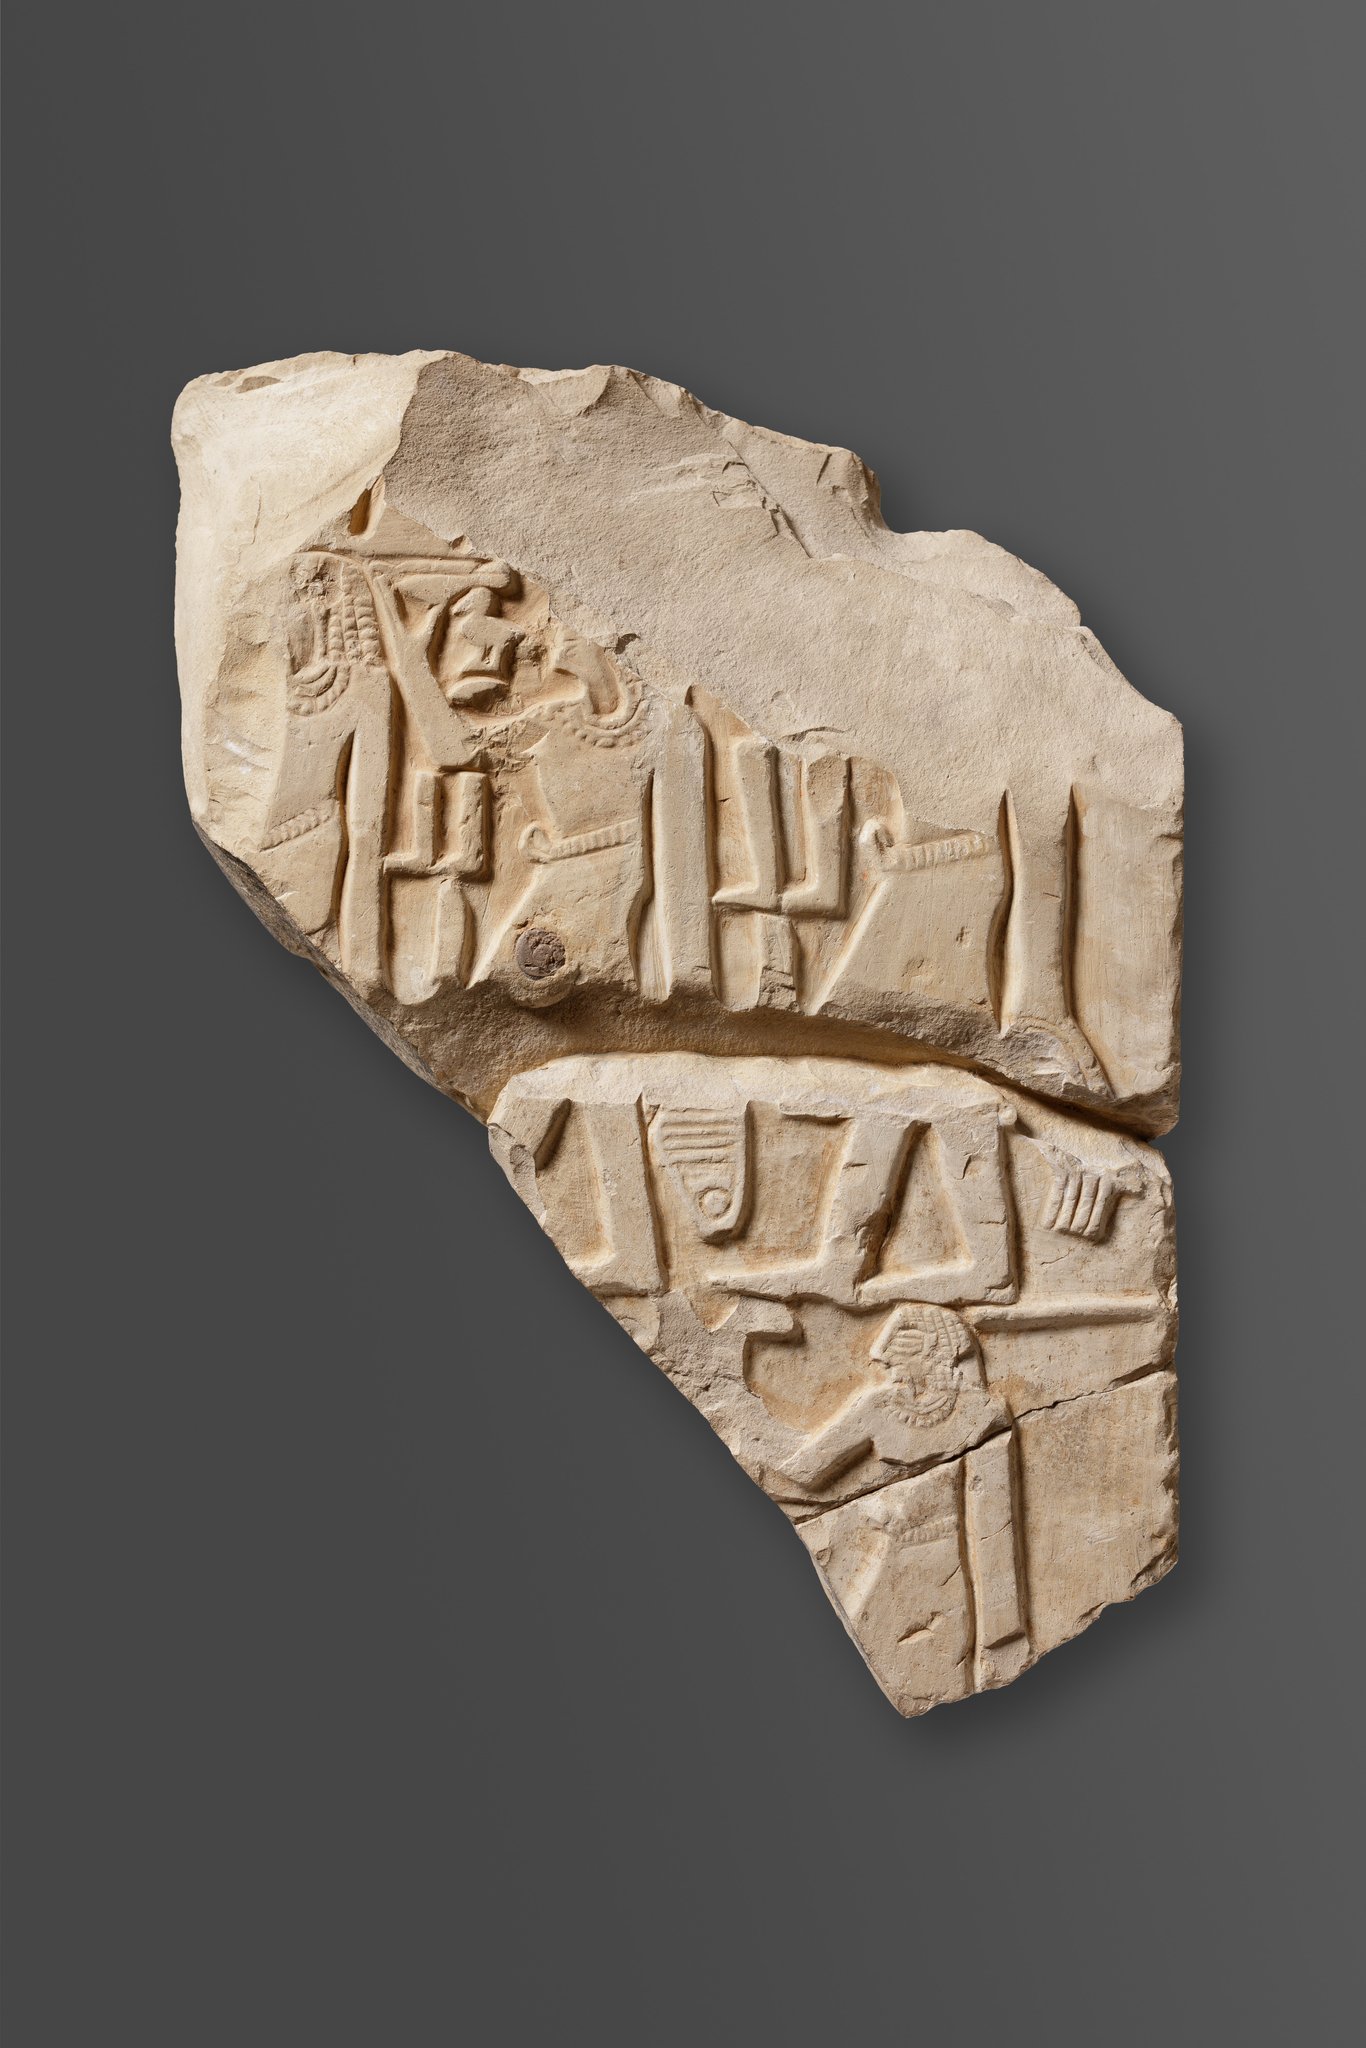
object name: stela fragment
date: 2100-2090 BCE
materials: limestone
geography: egypt